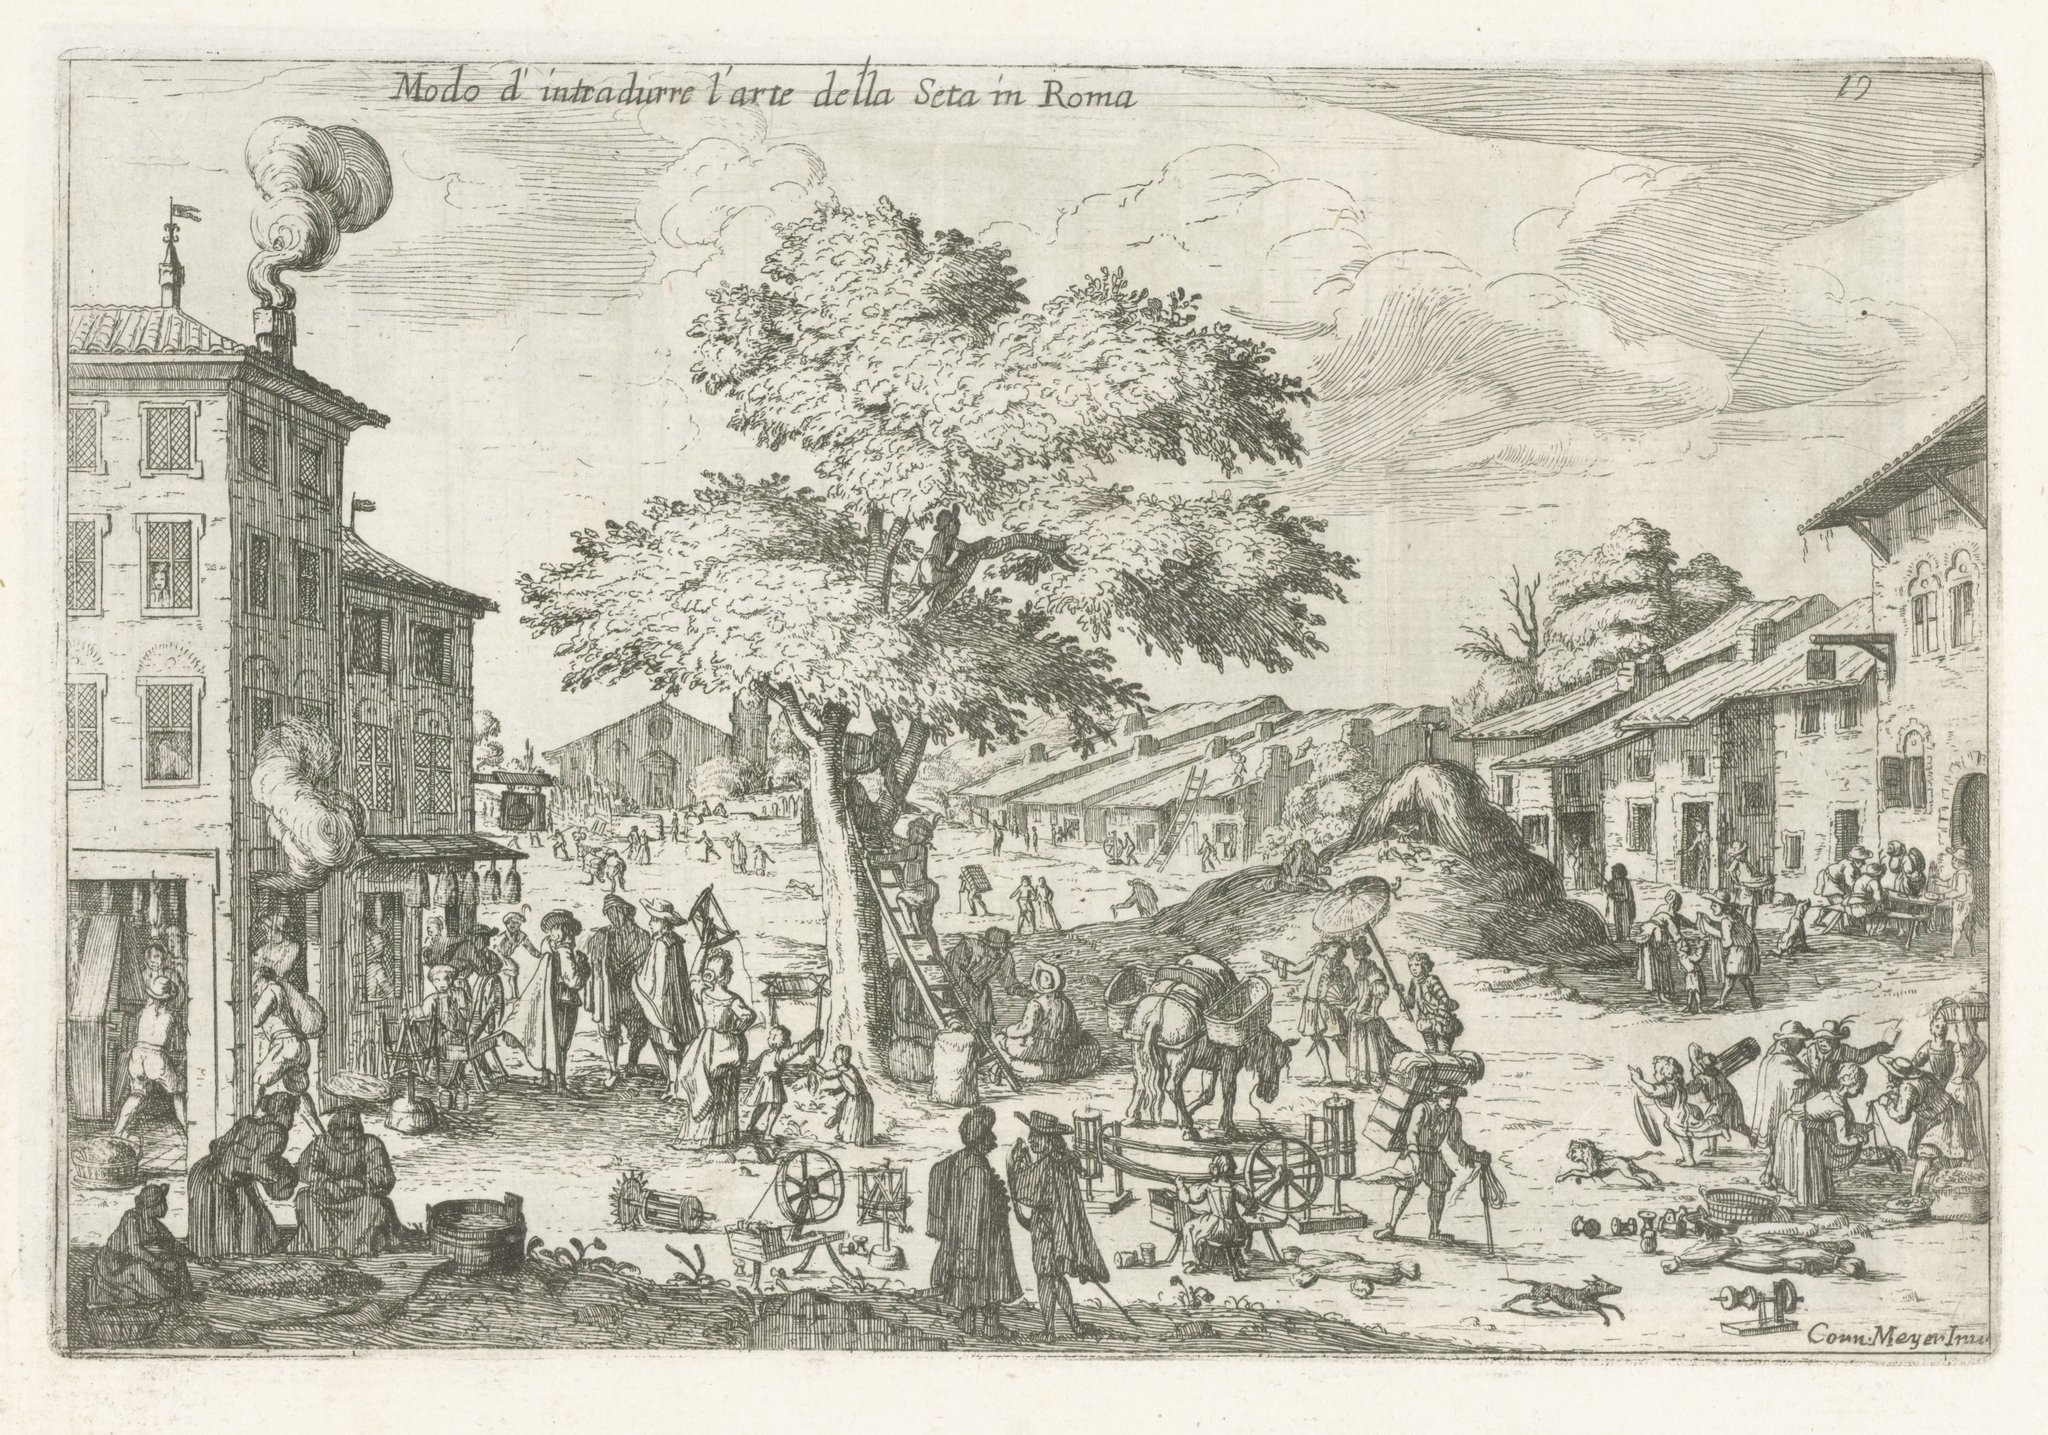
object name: print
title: Mogelijkheden om de zijdeproductie in Rome te bevorderen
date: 1696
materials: paper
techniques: etching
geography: rome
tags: special processes for silk fabric, silk (material ~ textile industry)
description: Mogelijkheden om de zijdeproductie in Rome te bevorderen. In een landschap houden diverse mensen zich bezig met de productie van zijde. Mannen klimmen in een moerbeiboom om cocons te zoeken. Met verschillende apparaten worden zijdedraden gesponnen.